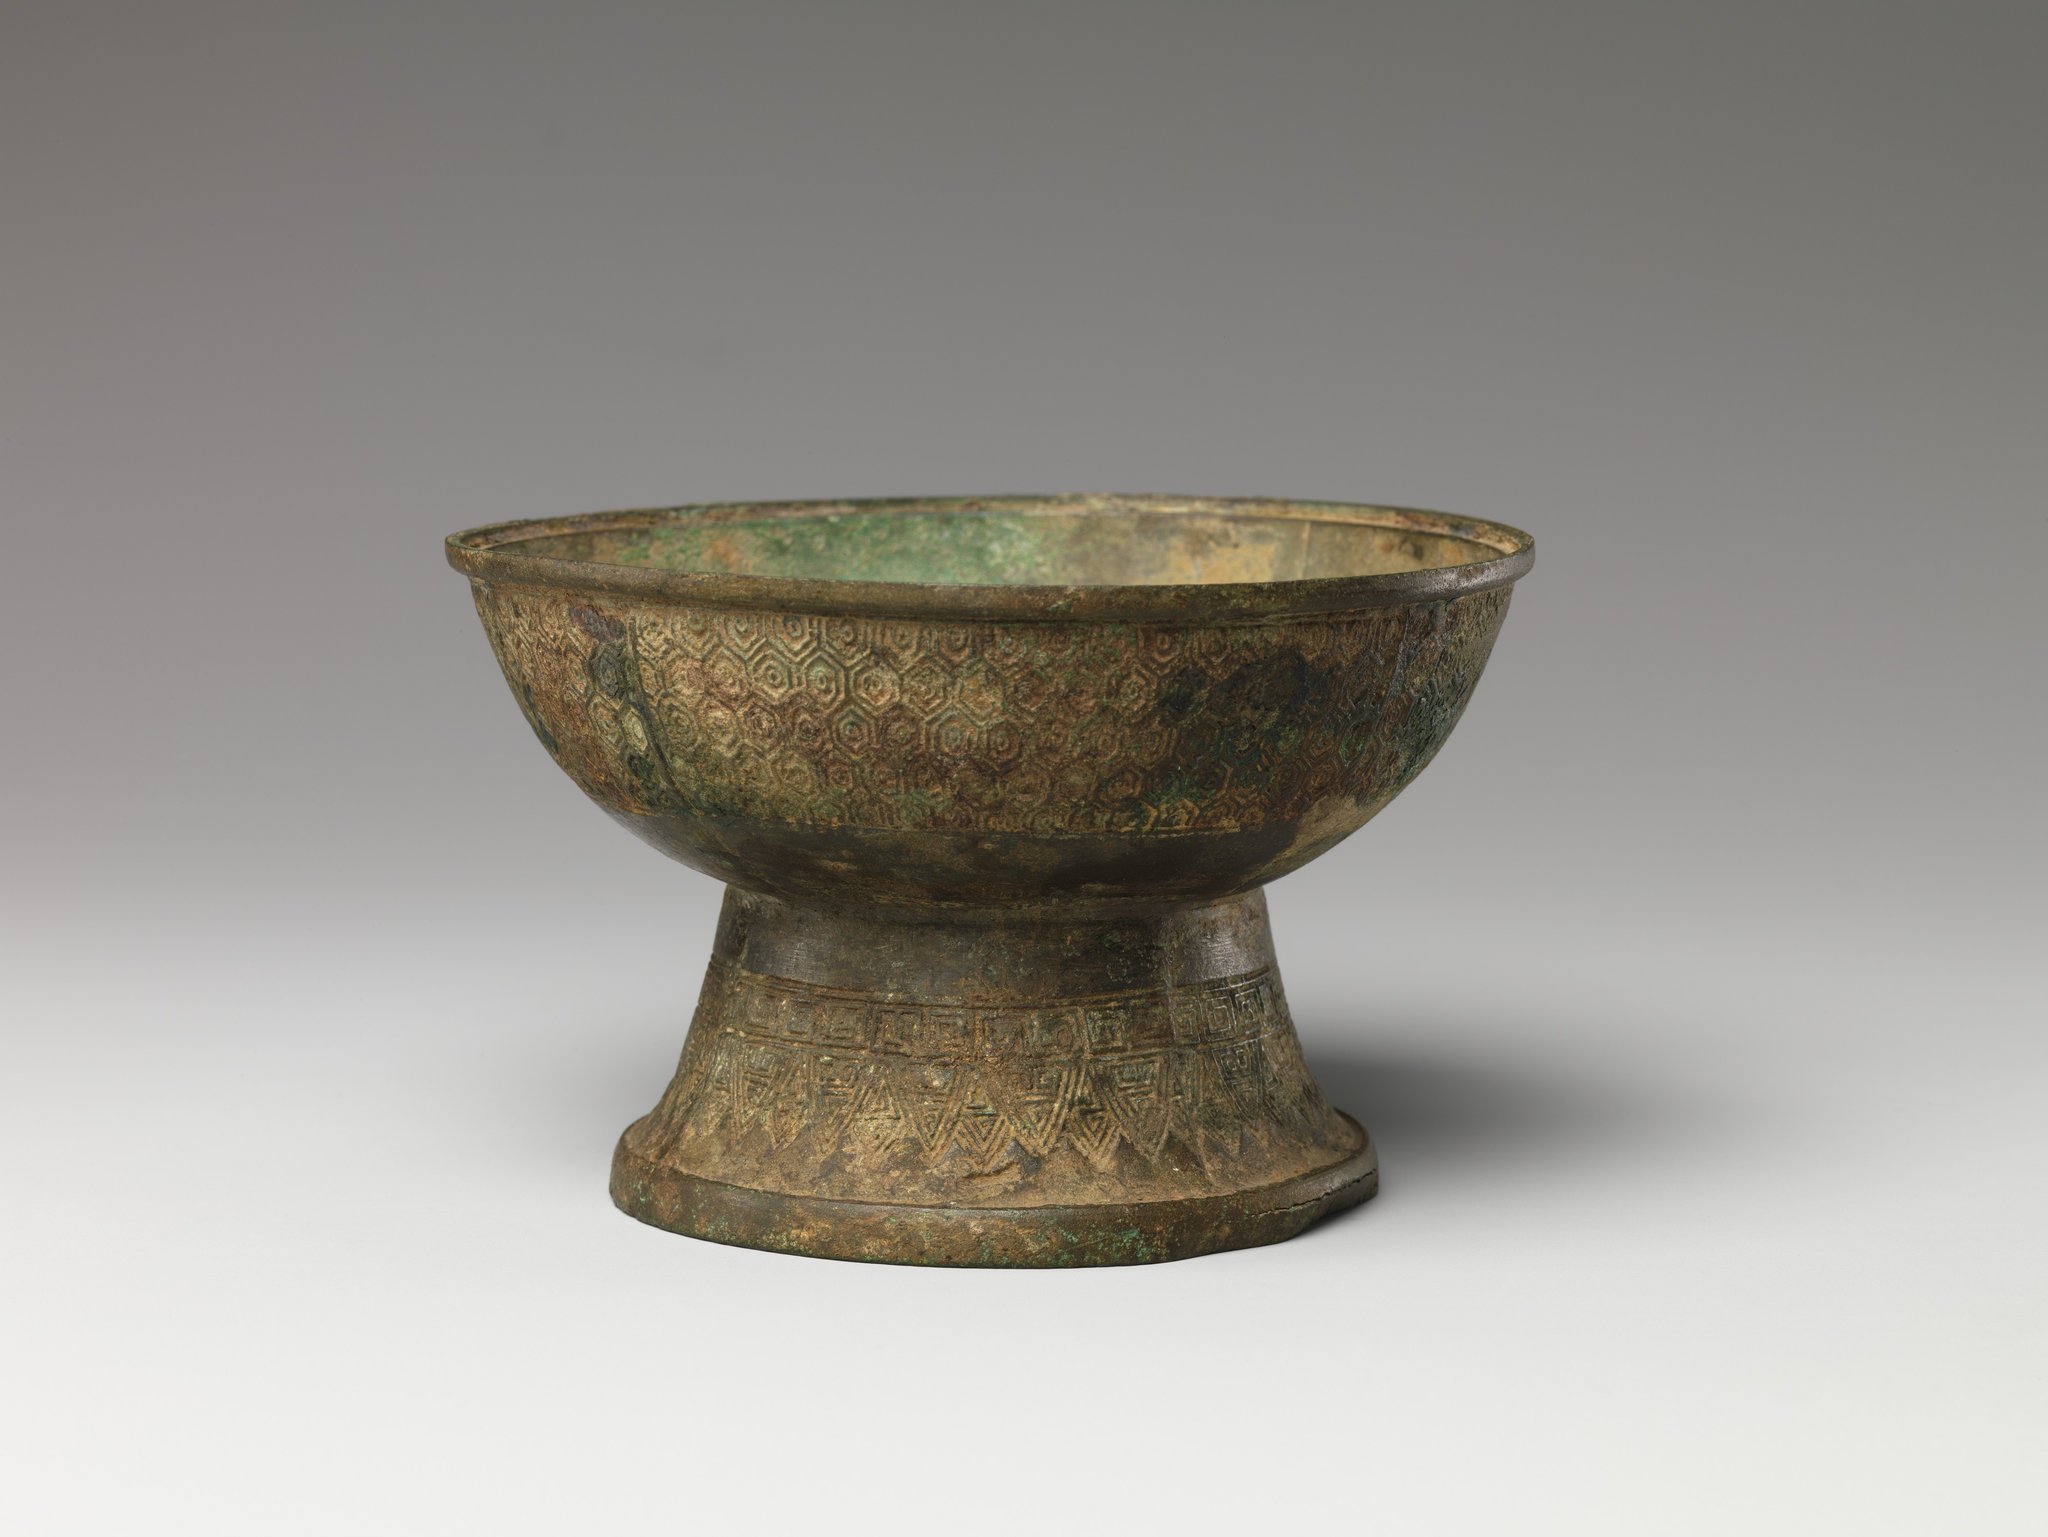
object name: bowl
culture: chinese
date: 770-221 BCE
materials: bronze